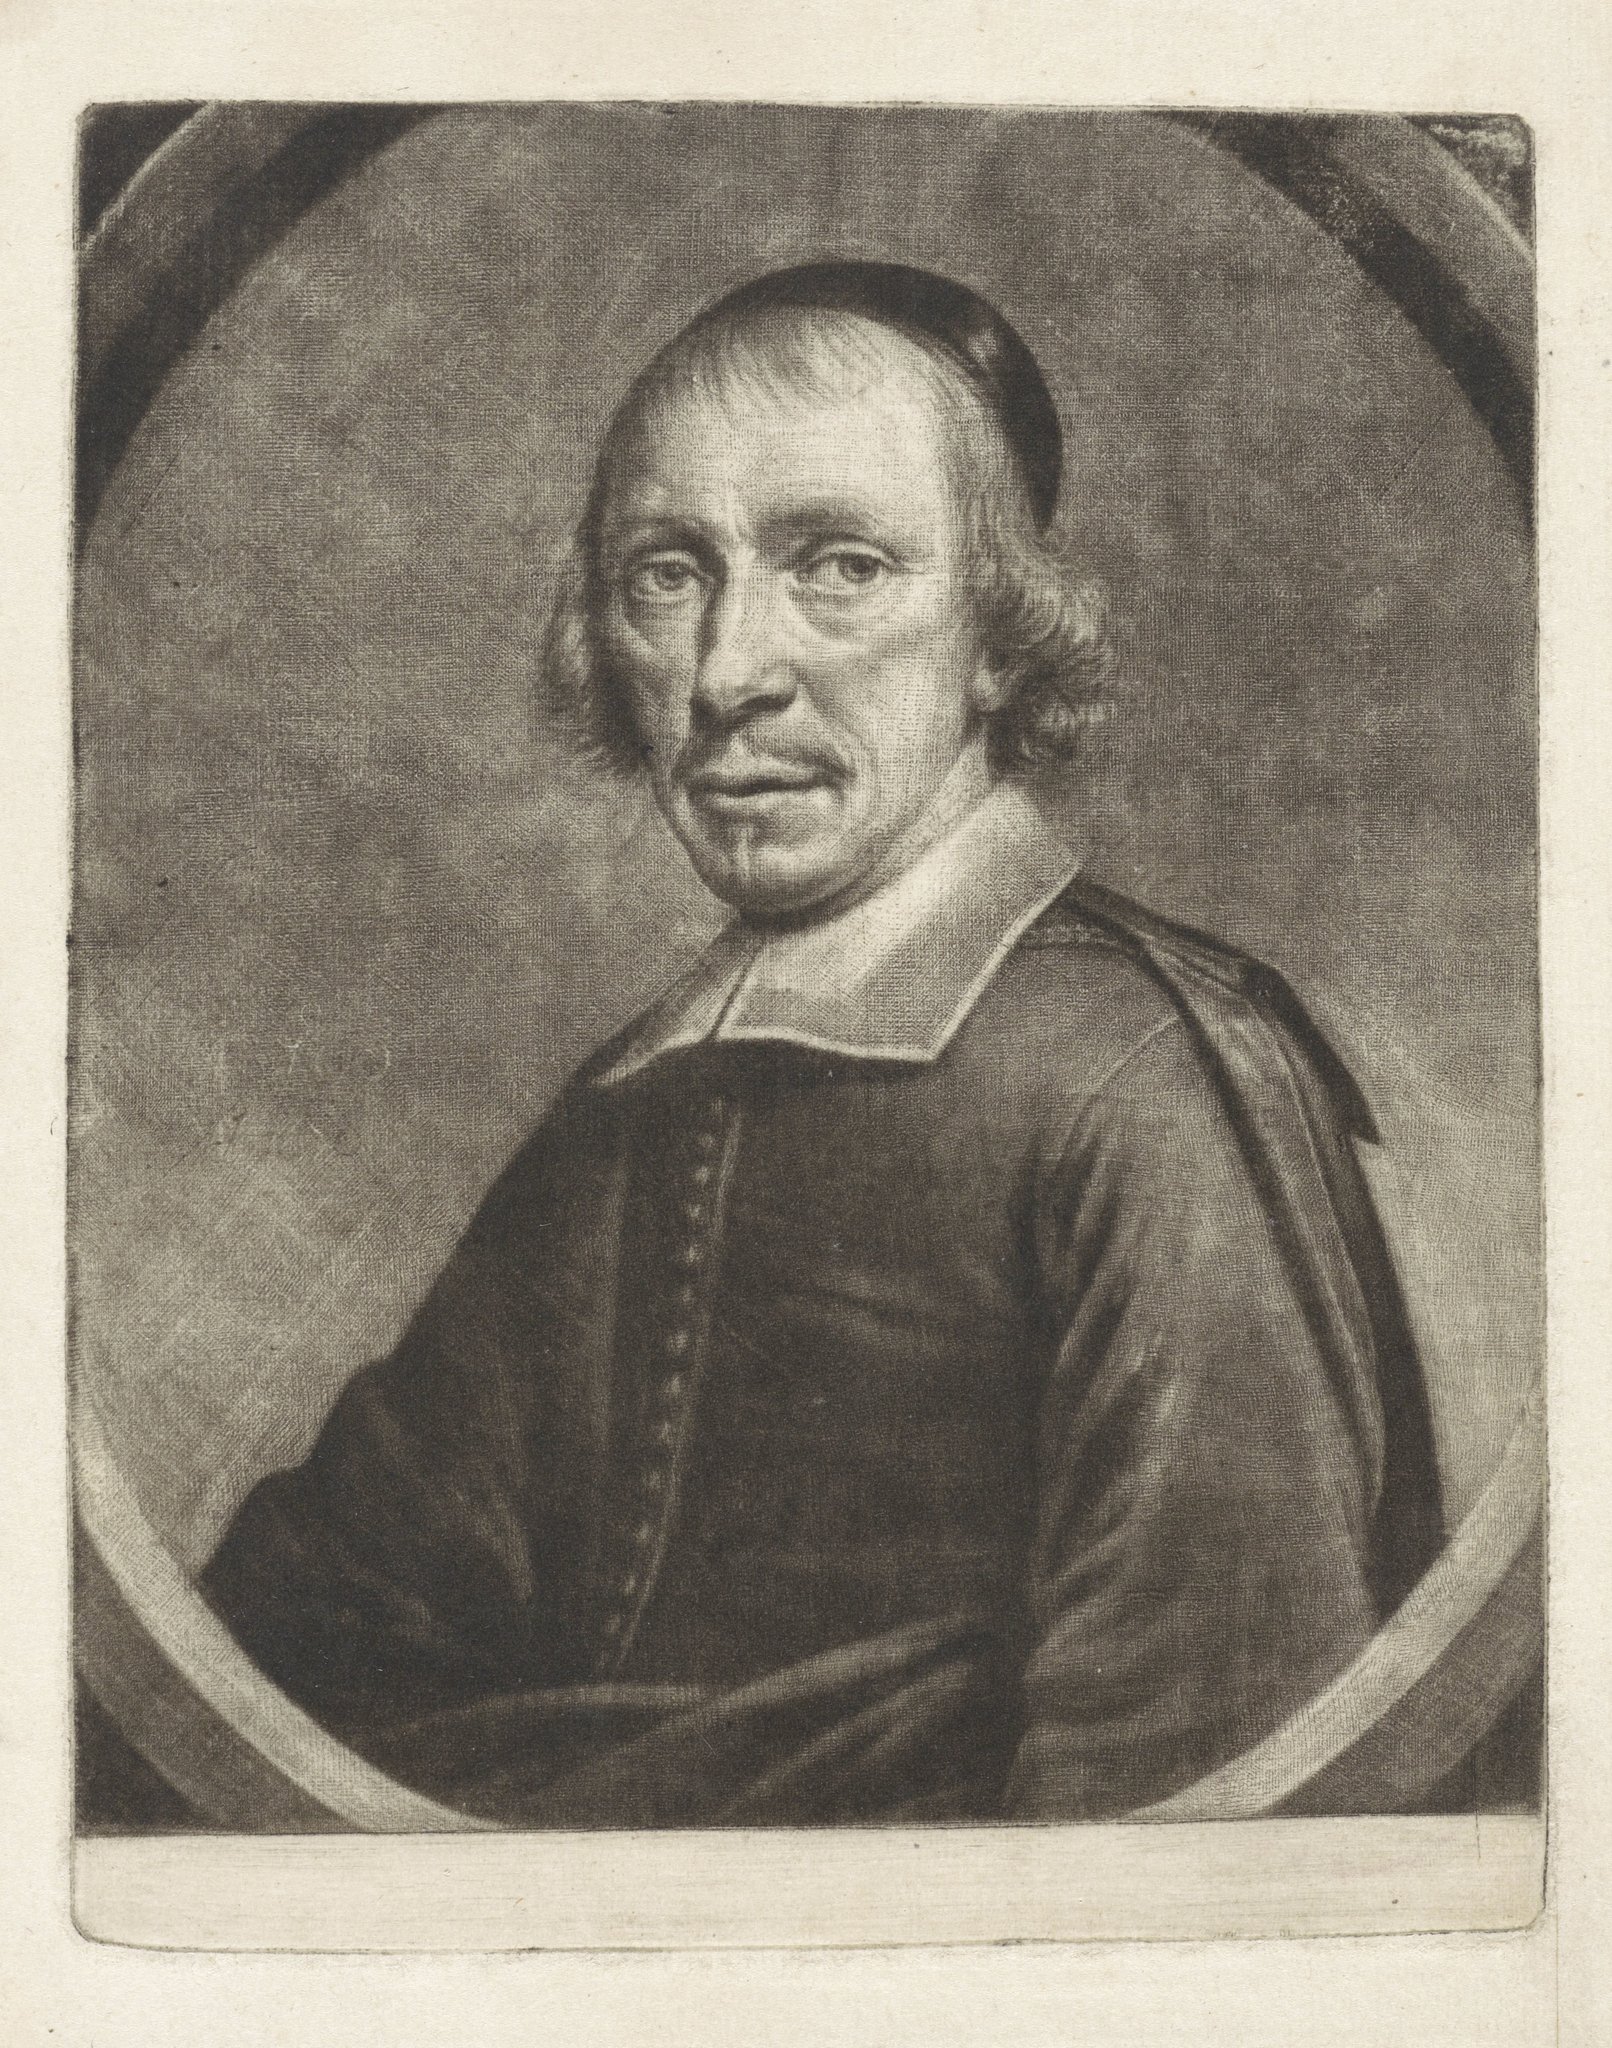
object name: print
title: Portret van Johannes Goethals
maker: jan verkolje (i)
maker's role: draughtsman, painter, print maker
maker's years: 1650-1693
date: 1670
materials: paper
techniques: mezzotint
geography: delft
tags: delft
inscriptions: collector's mark: Lugt 240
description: Johannes Goethals, hofpredikant van prins Frederik Hendrik, op 60-jarige leeftijd.